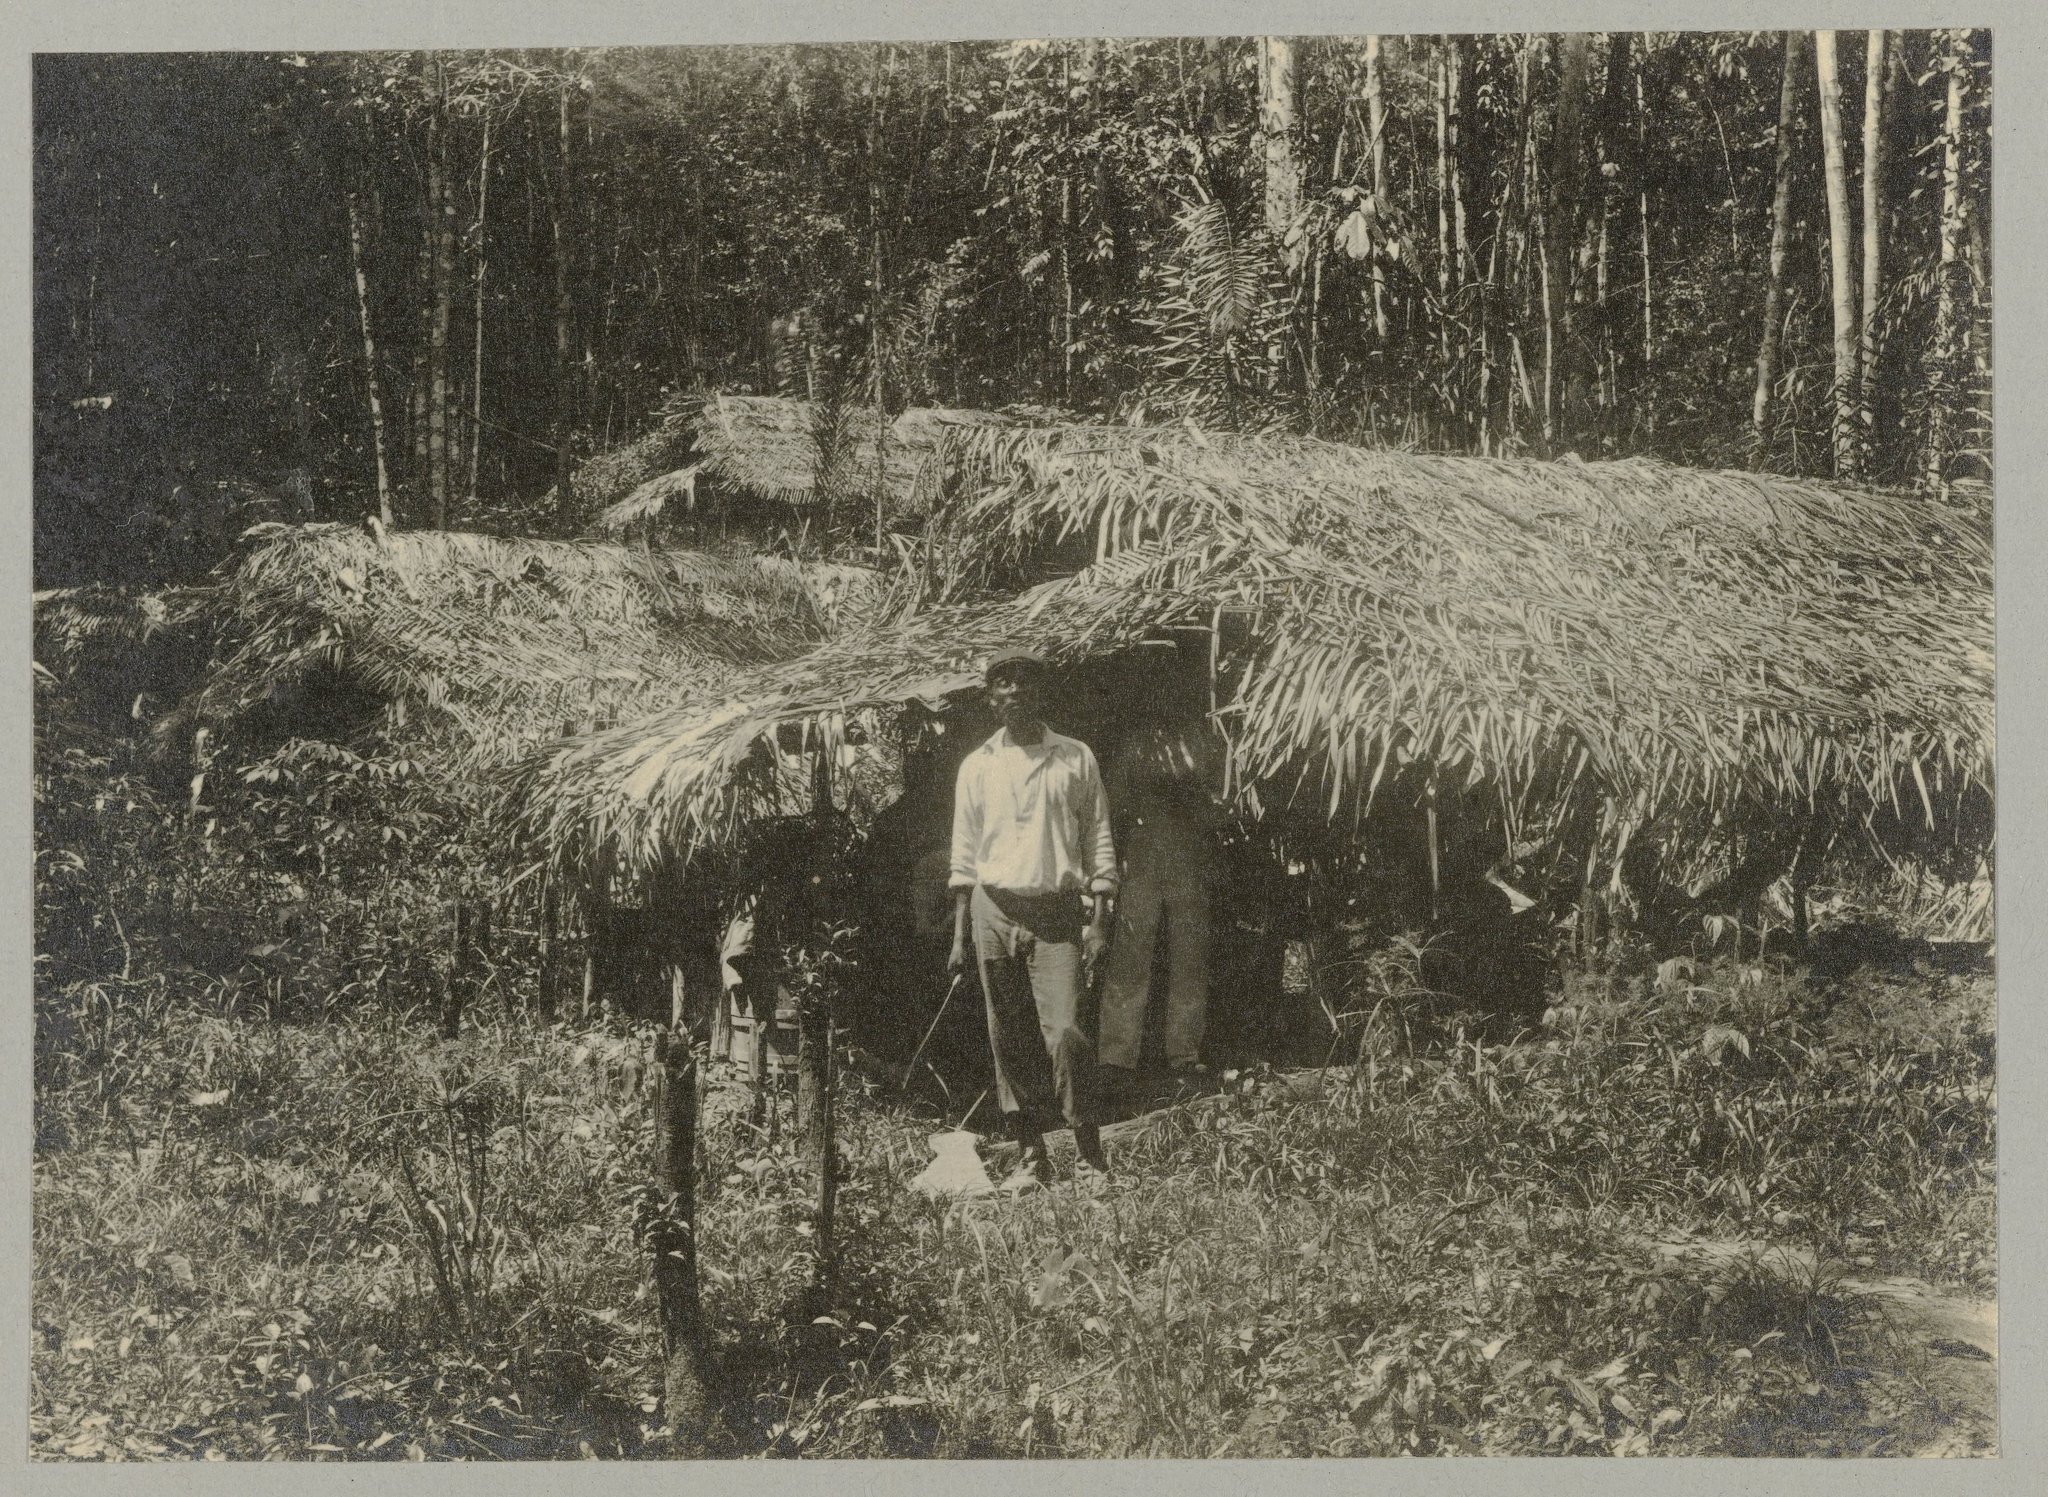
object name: photograph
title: Kaplijn bezuiden het balatableederskamp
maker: hendrik doijer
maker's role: engineer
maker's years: 1863-1925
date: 1903-1910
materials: photographic support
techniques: gelatin silver print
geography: suriname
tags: suriname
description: Kaplijn in het oerword ten zuiden van het kamp van de balatableeders (balata is het hars getapt van de bolletrieboom). Onderdeel van het fotoalbum Souvenir de Voyage (deel 5), over het leven van de familie Doijer in en rond de plantage Ma Retraite in Suriname in de jaren 1903-1910.